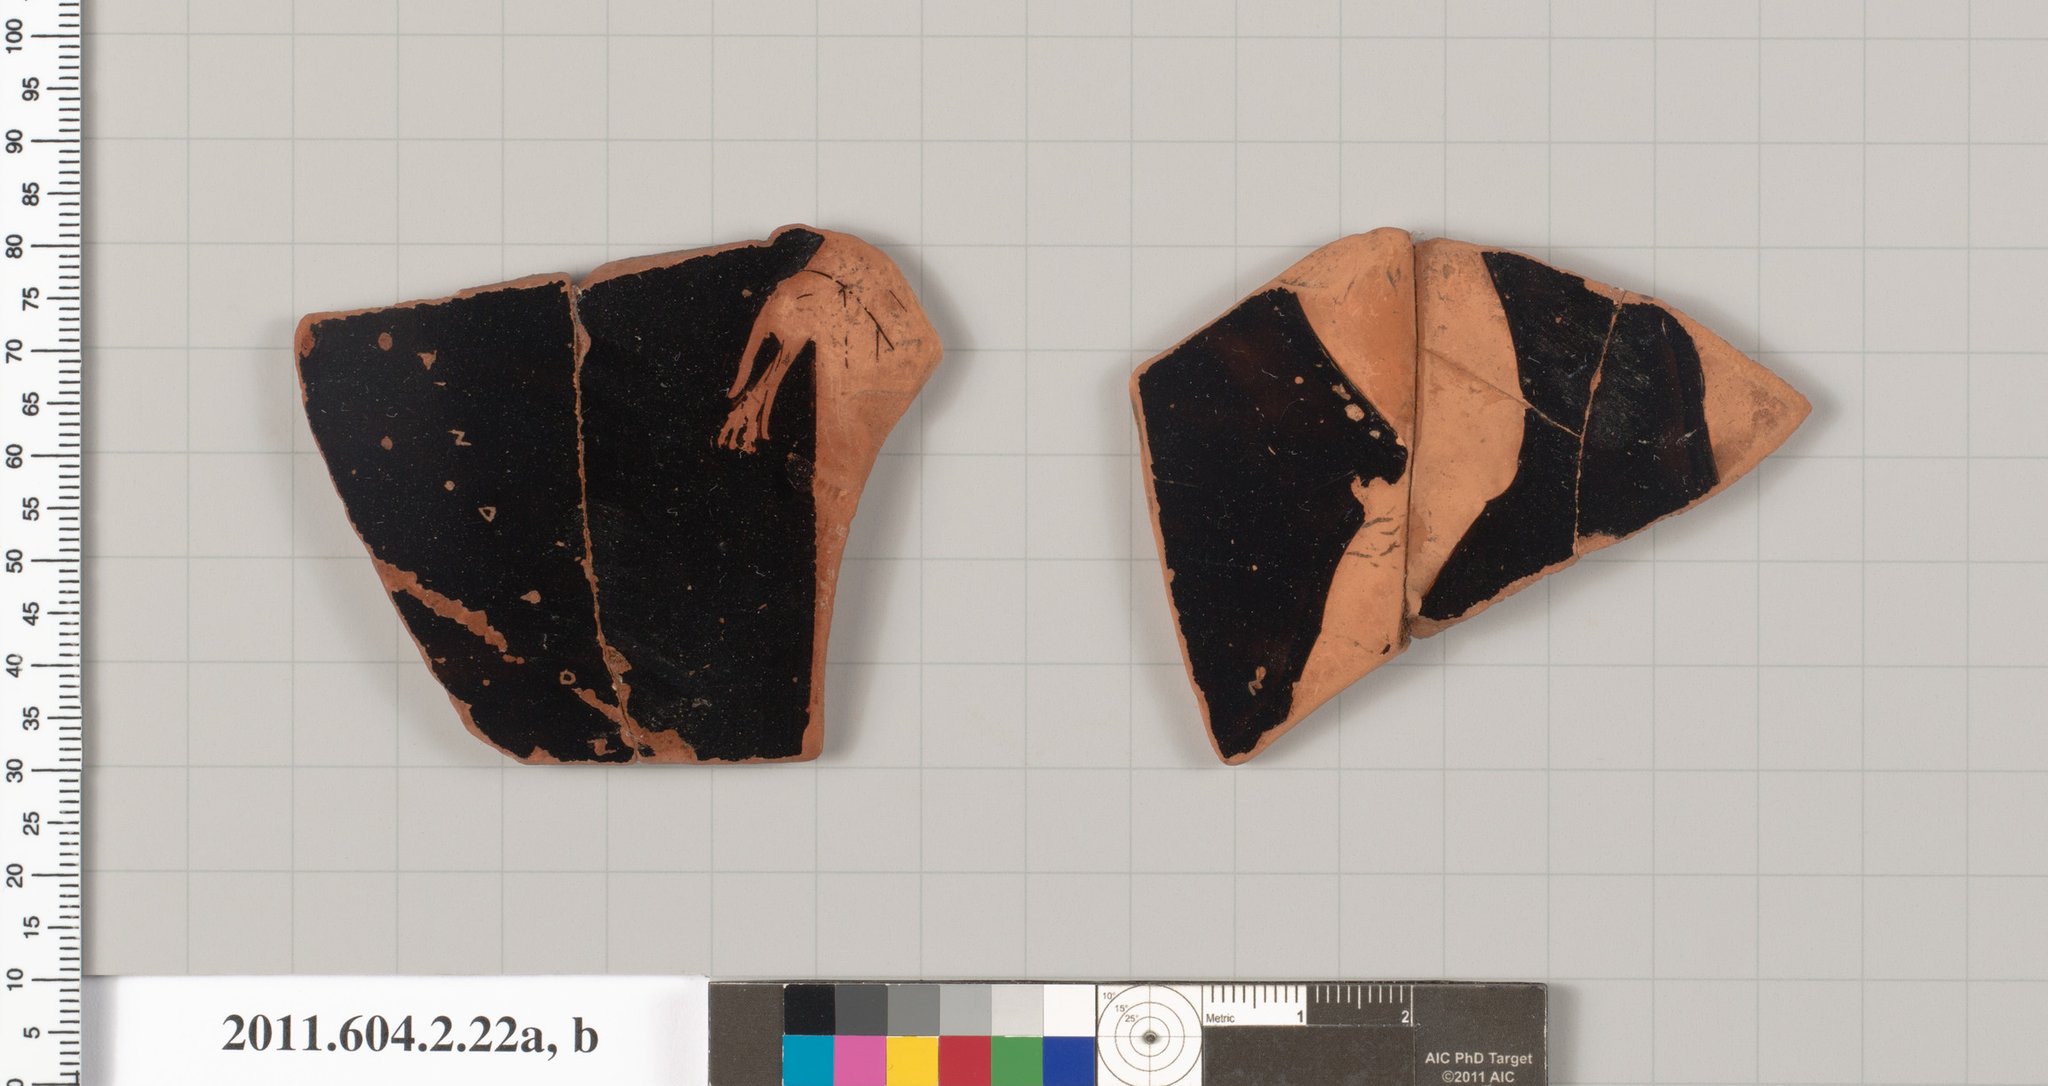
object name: psykter fragment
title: Terracotta fragments of a psykter (vase for cooling wine)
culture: greek, attic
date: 520-500 BCE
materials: terracotta